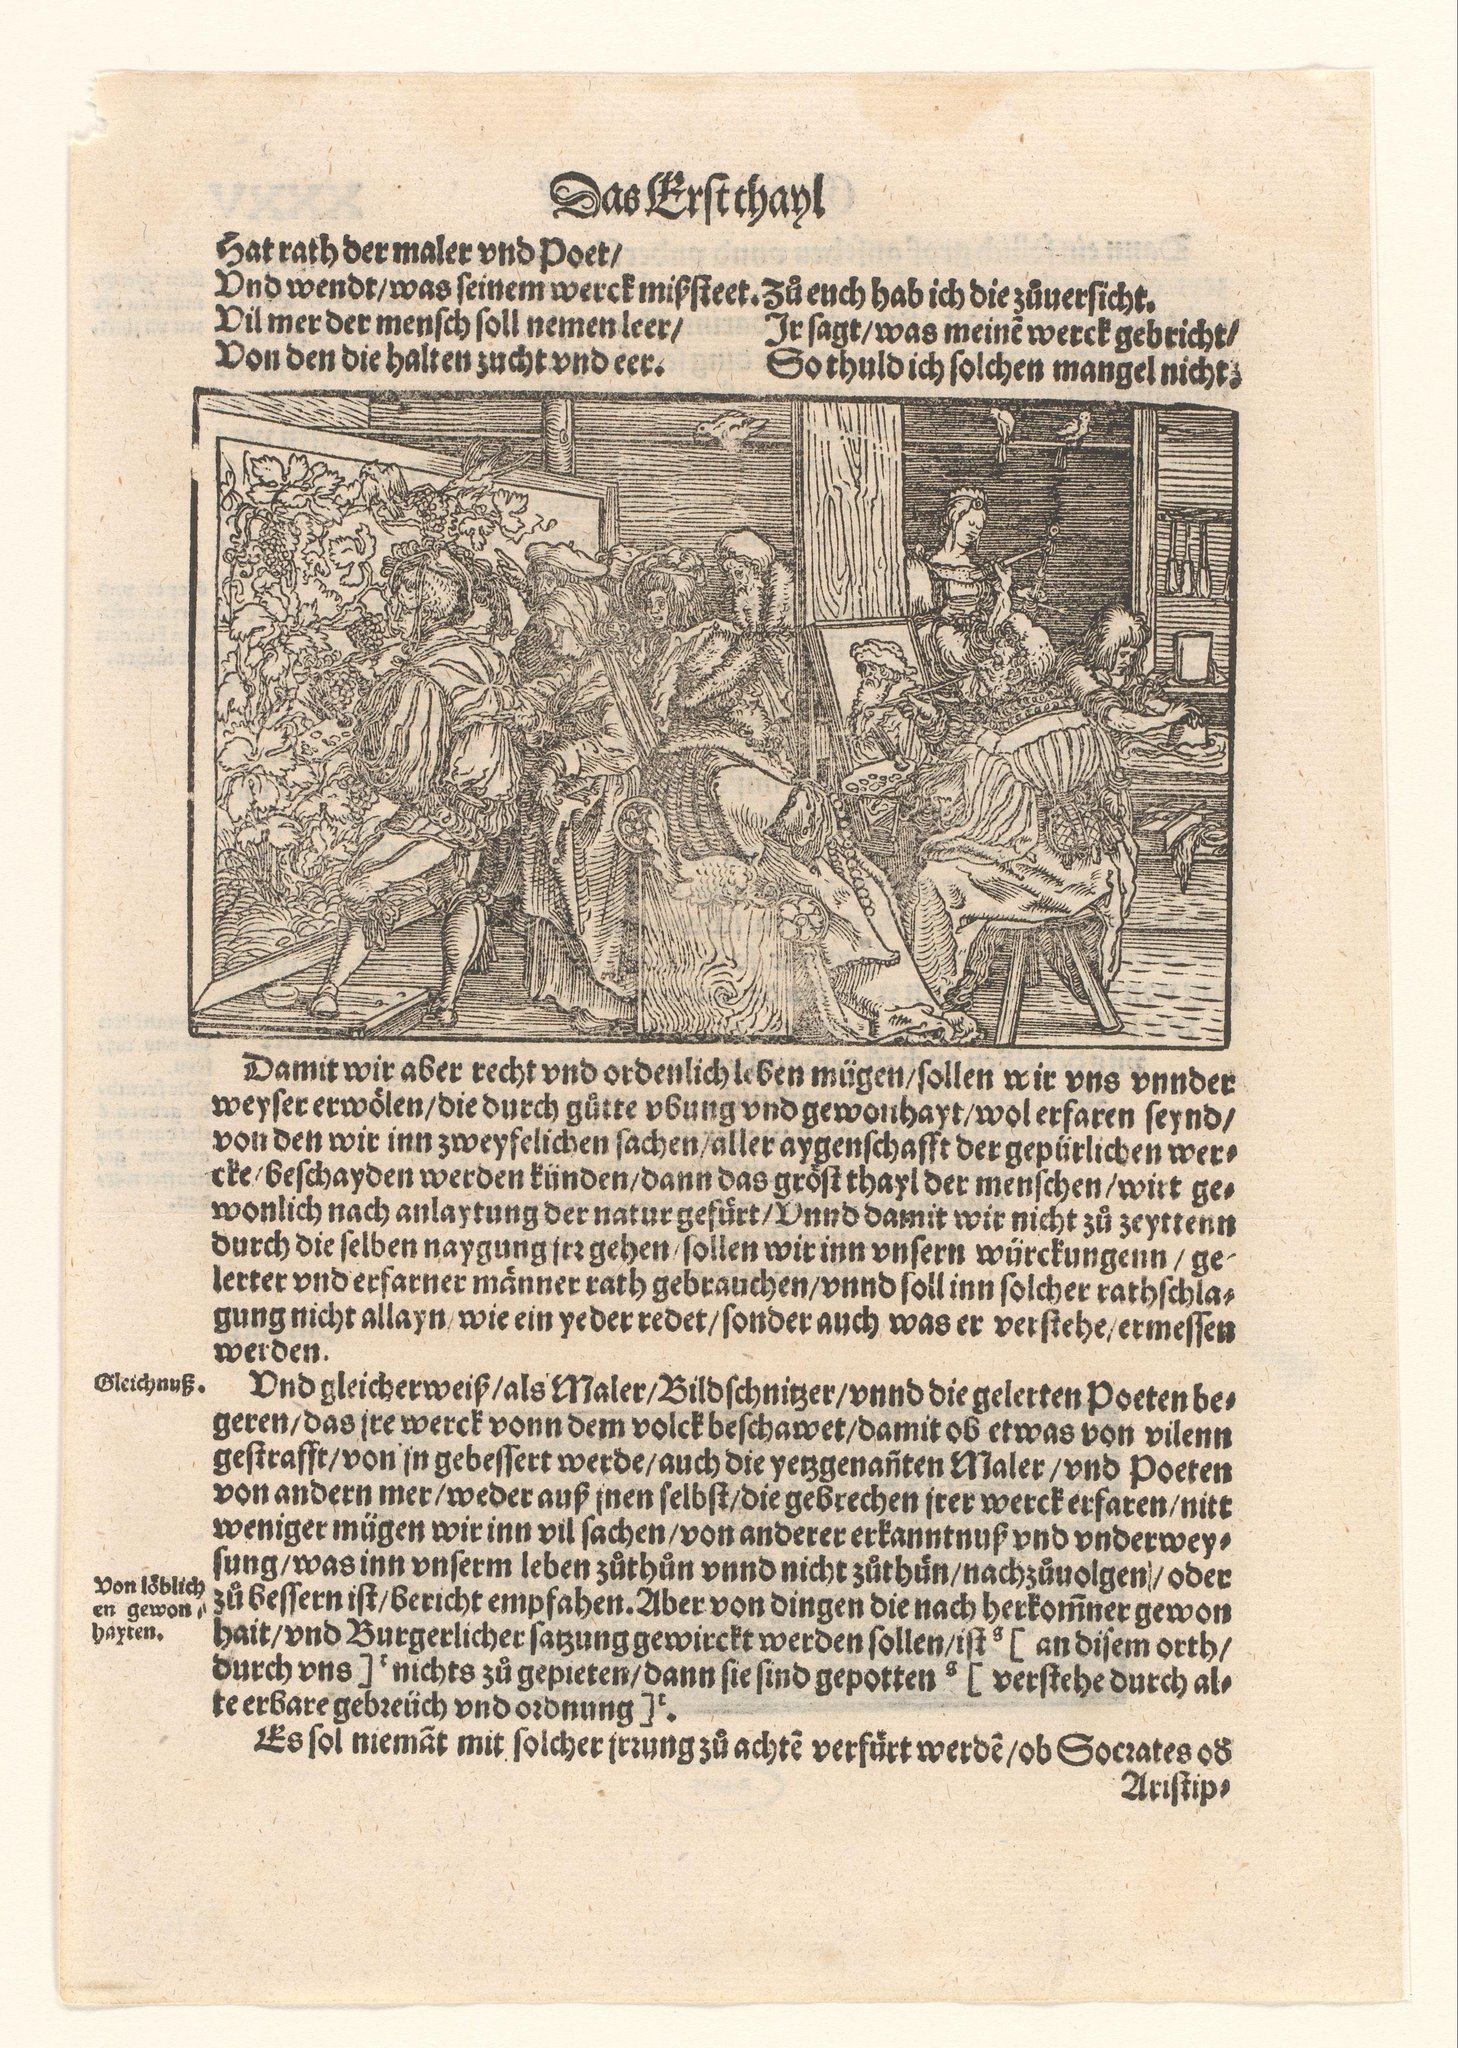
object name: book illustration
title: Schilderswerkplaats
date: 1540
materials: paper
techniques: letterpress printing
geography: germany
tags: workshop, studio ~ painter, painter working from clothed model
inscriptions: collector's mark: Lugt 2228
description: Prent uit: Cicero, Marcus Tullius. Officia (...). Augsburg: Heinrich Steiner, 1540. De prent is eerder gebruikt in edities van dit werk uit 1531 en 1533, en later waarschijnlijk nog in 1545. De prent is ook gebruikt in: Petrarca, Francesco. Von der Artzney bayder Glück, des guten und widerwertigen: unnd weß sich ain yeder inn Gelück und Unglück halten sol (...). Augsburg: Heinrich Steiner, 1532. Deze uitgave is ook bekend onder de titel 'Trostspiegel in Glück und Unglück'.